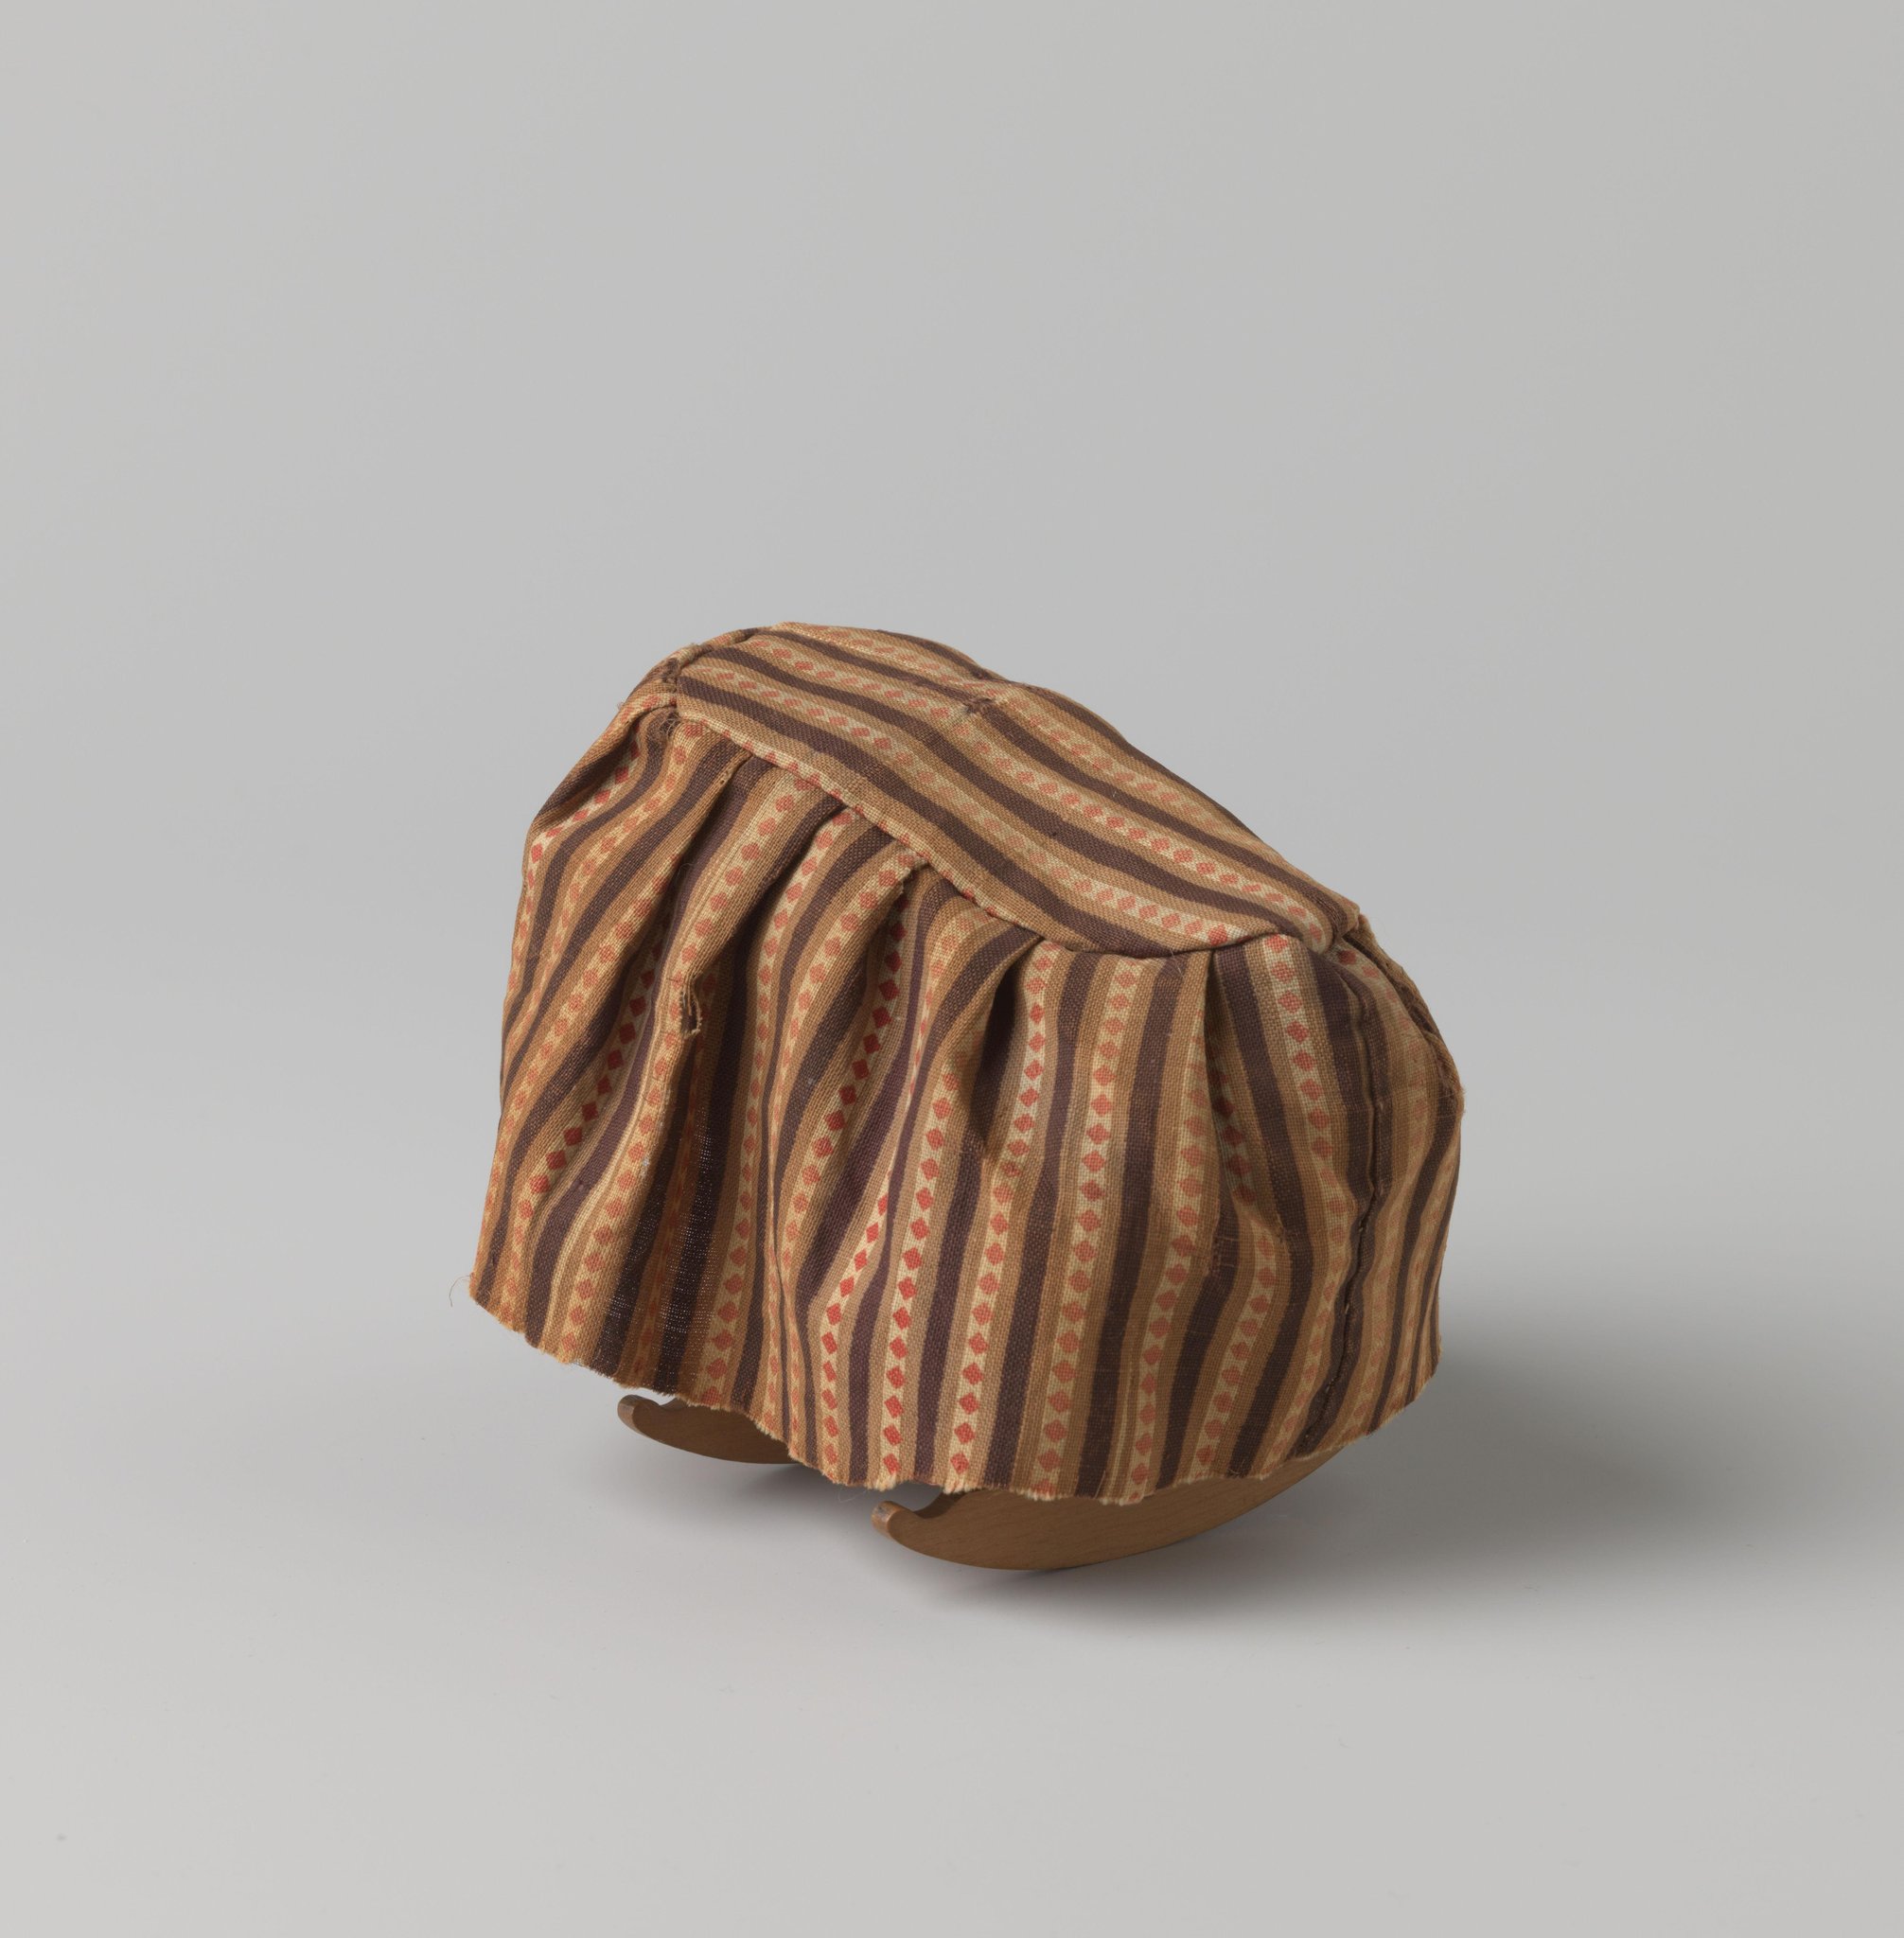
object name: wiegenkleed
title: Kleed, bedrukt met streep- en ruitmotief in bruin, wit en rood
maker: Anonymous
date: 1750-1800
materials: cotton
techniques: printing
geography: amsterdam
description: Wiegenkleed van bedrukt katoen met streep- en ruitmotief in de kleurstelling bruin, wit en rood.